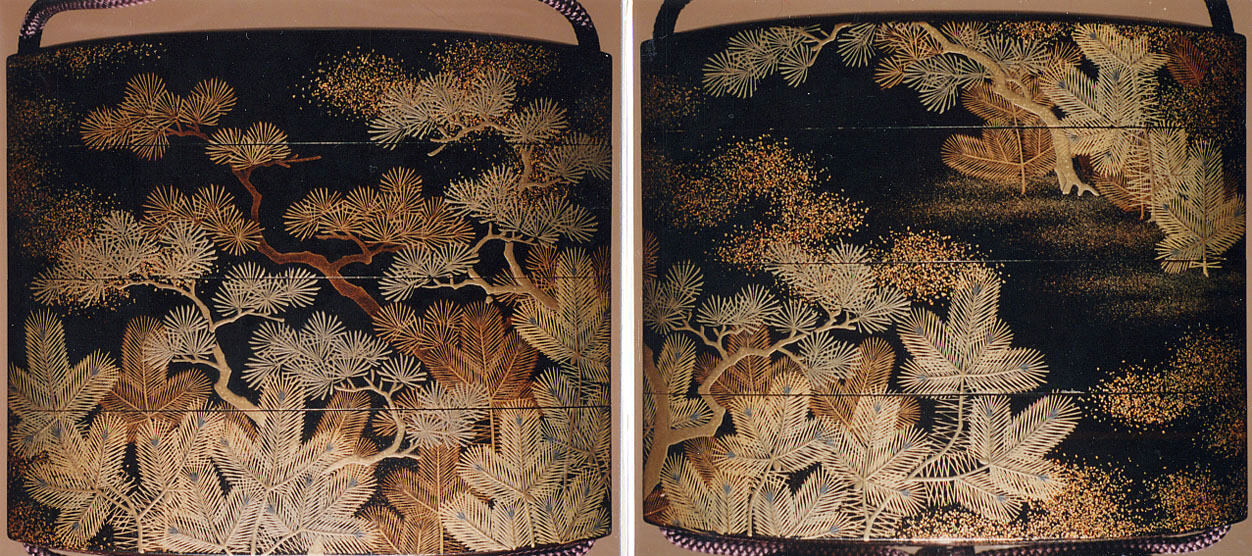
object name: inrō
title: Case (Inrō) with Design of Young Pines Growing beside Gnarled Pine Trees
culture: japanese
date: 1801-1900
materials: gold, lacquer, silver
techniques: fundame, hiramakie, roiro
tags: trees